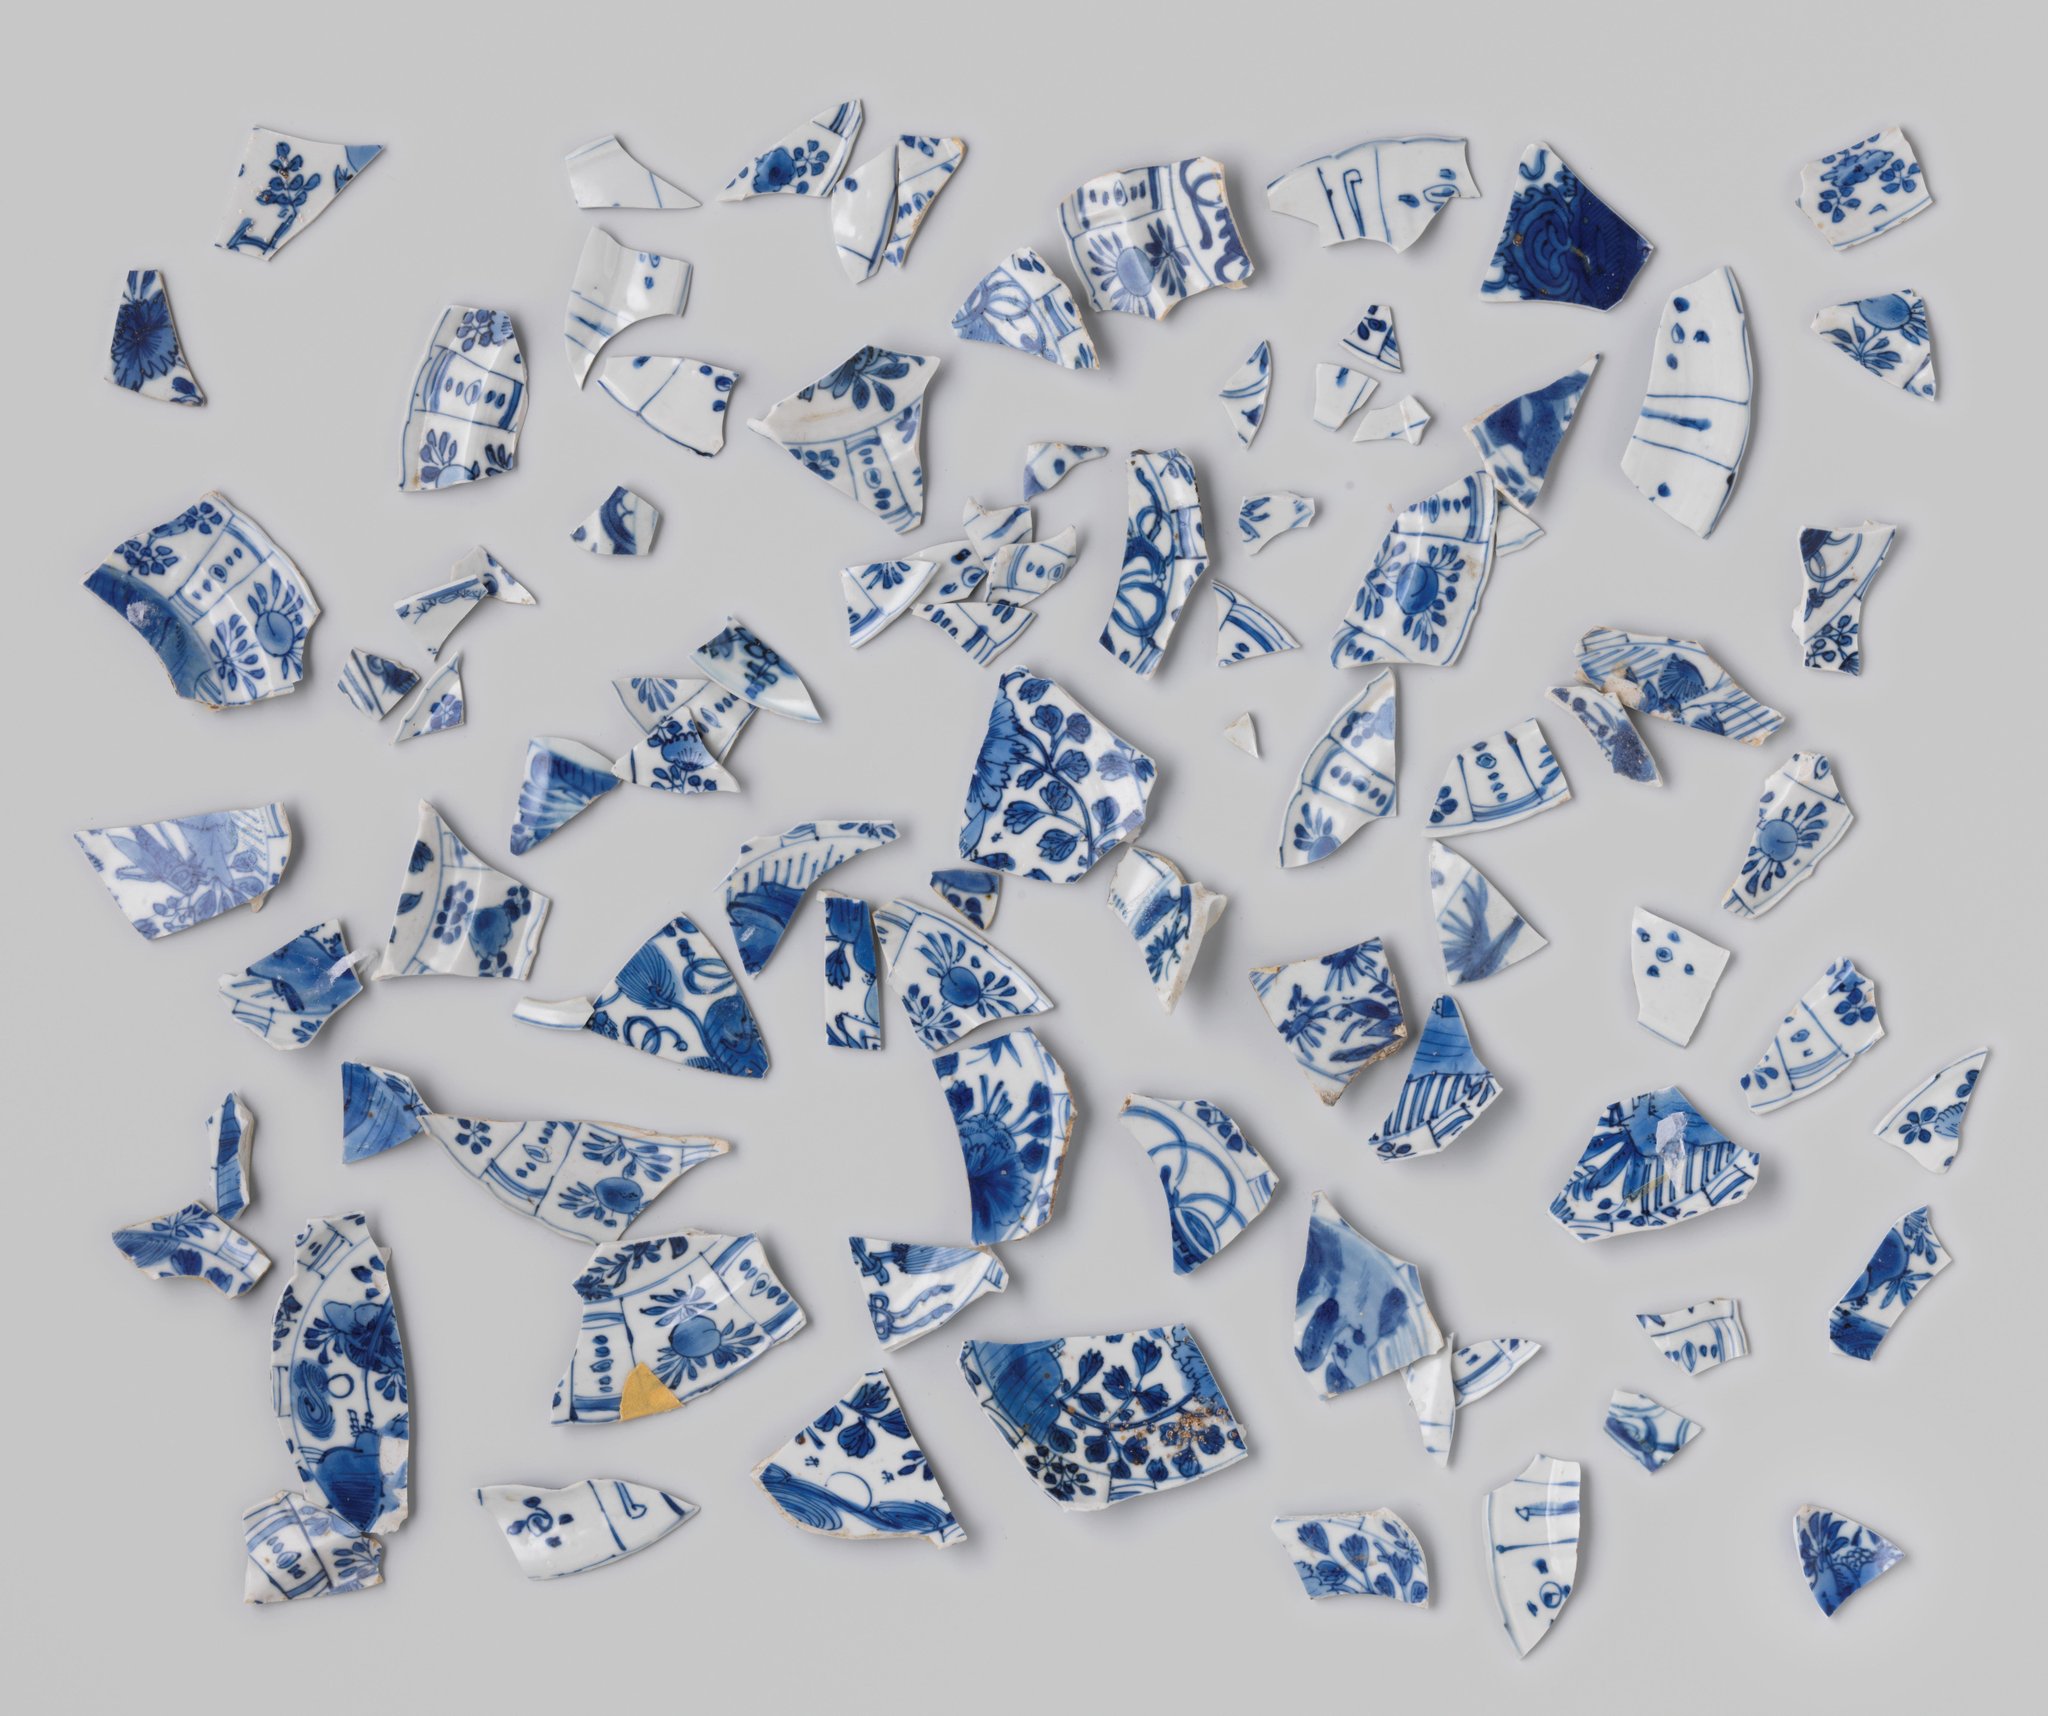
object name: plate dish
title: Scherven van borden uit V.O.C.-schip de 'Witte Leeuw'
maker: Anonymous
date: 1613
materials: bone china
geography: jingdezhen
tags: verenigde oostindische compagnie, sint-helena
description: Scherven van borden uit V.O.C.-schip de 'Witte Leeuw'.